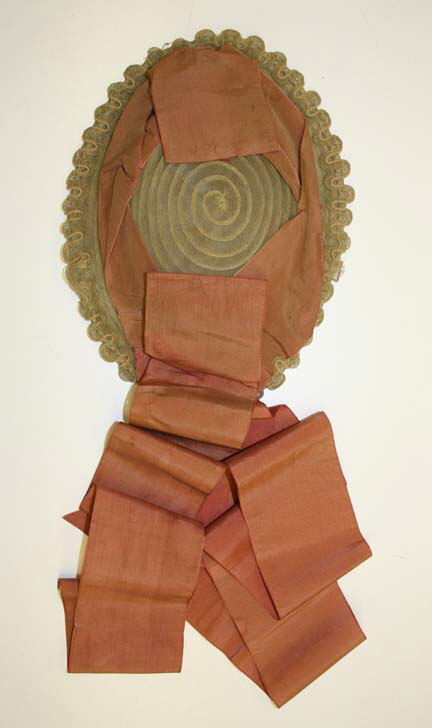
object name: hat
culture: american or european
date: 1867-1869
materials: silk, fiber